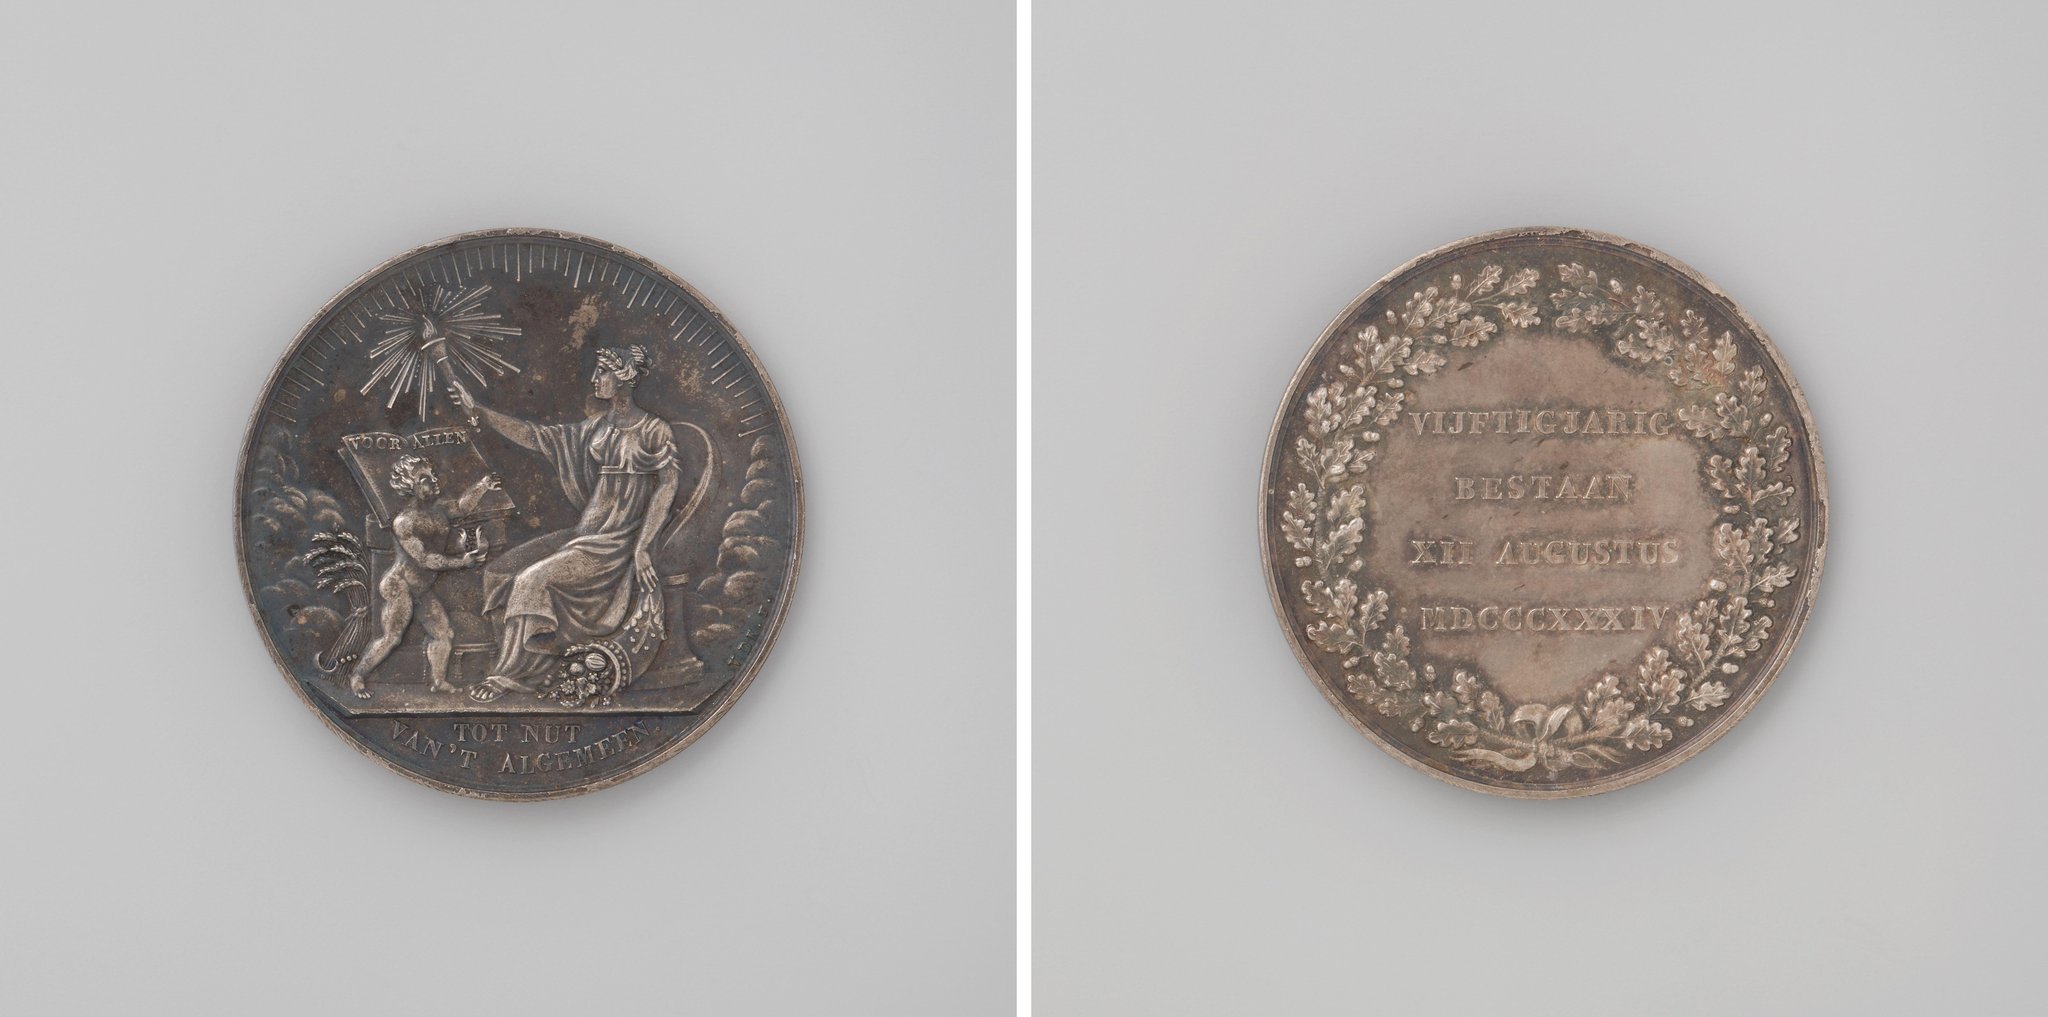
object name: history medal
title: Vijftigjarig bestaan van de Maatschappij tot Nut van 't Algemeen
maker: david van der kellen (1804-1879)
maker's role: die cutter, draughtsman, print maker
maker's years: 1804-1879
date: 1834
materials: silver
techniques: striking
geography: utrecht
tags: maatschappij tot nut van 't algemeen